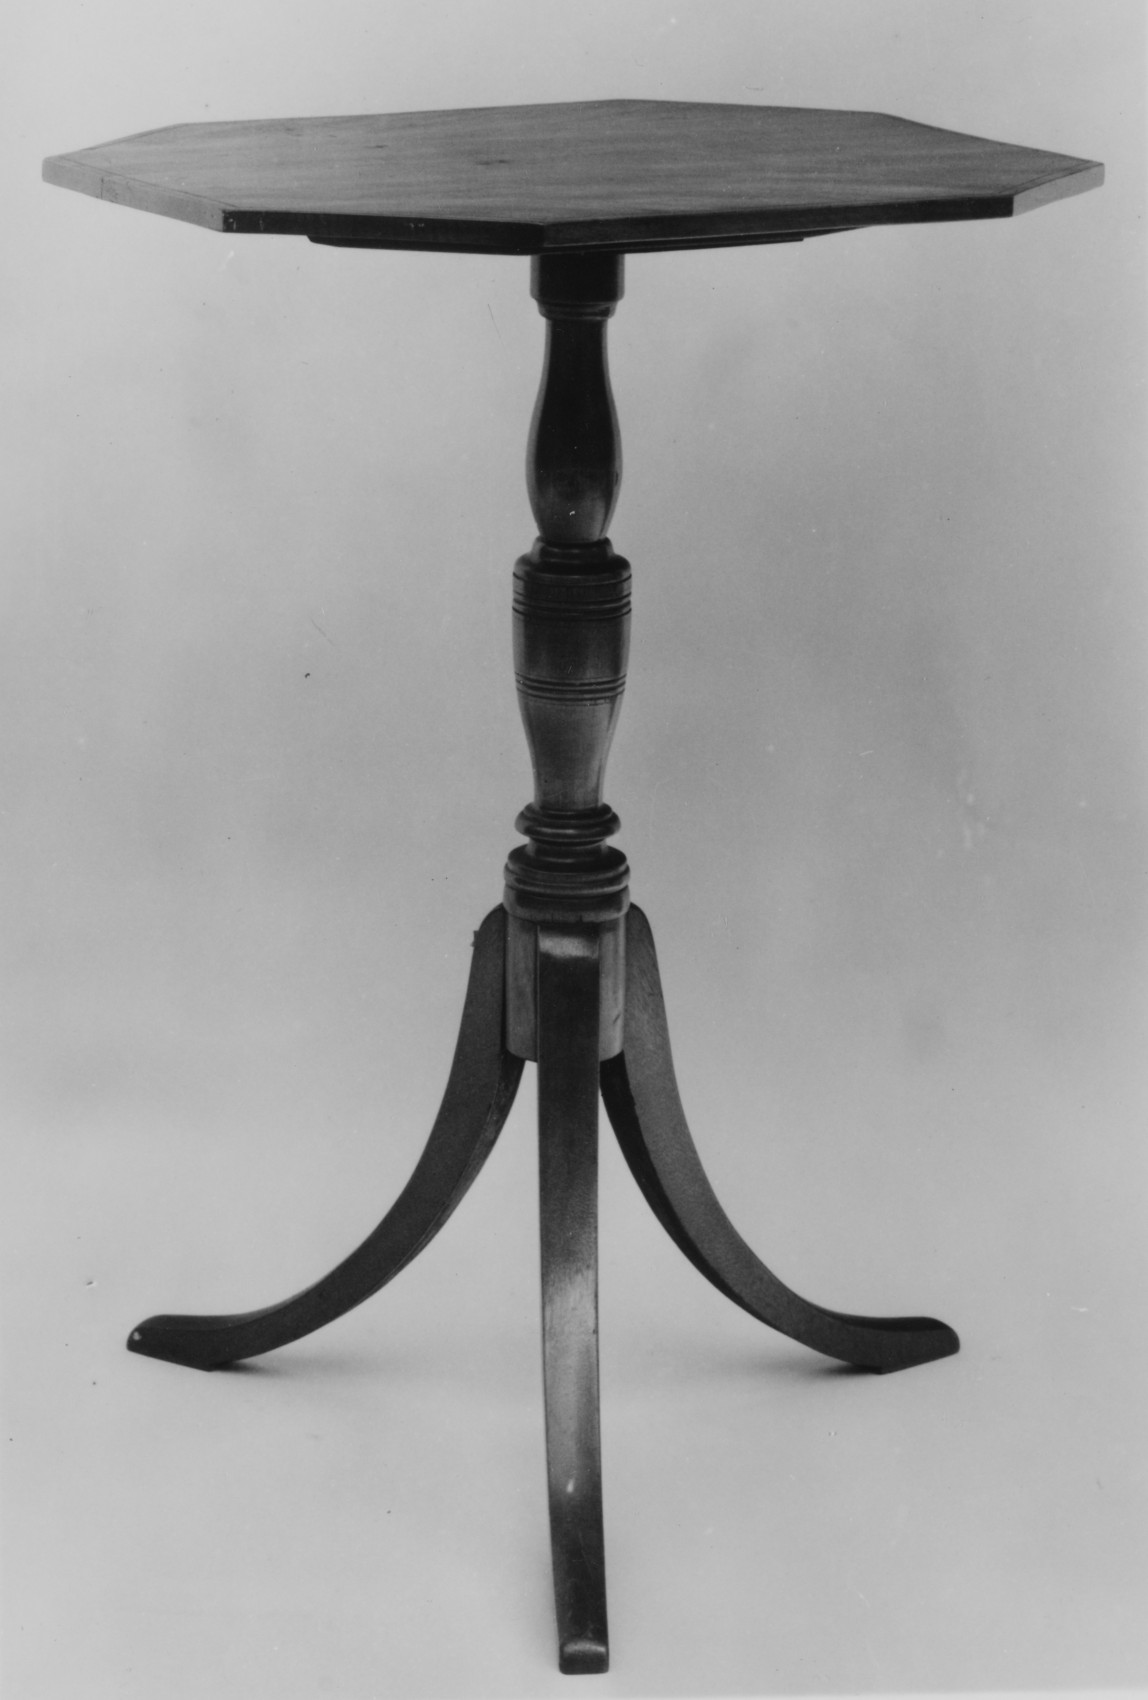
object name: candle stand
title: Candlestand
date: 1800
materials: wood